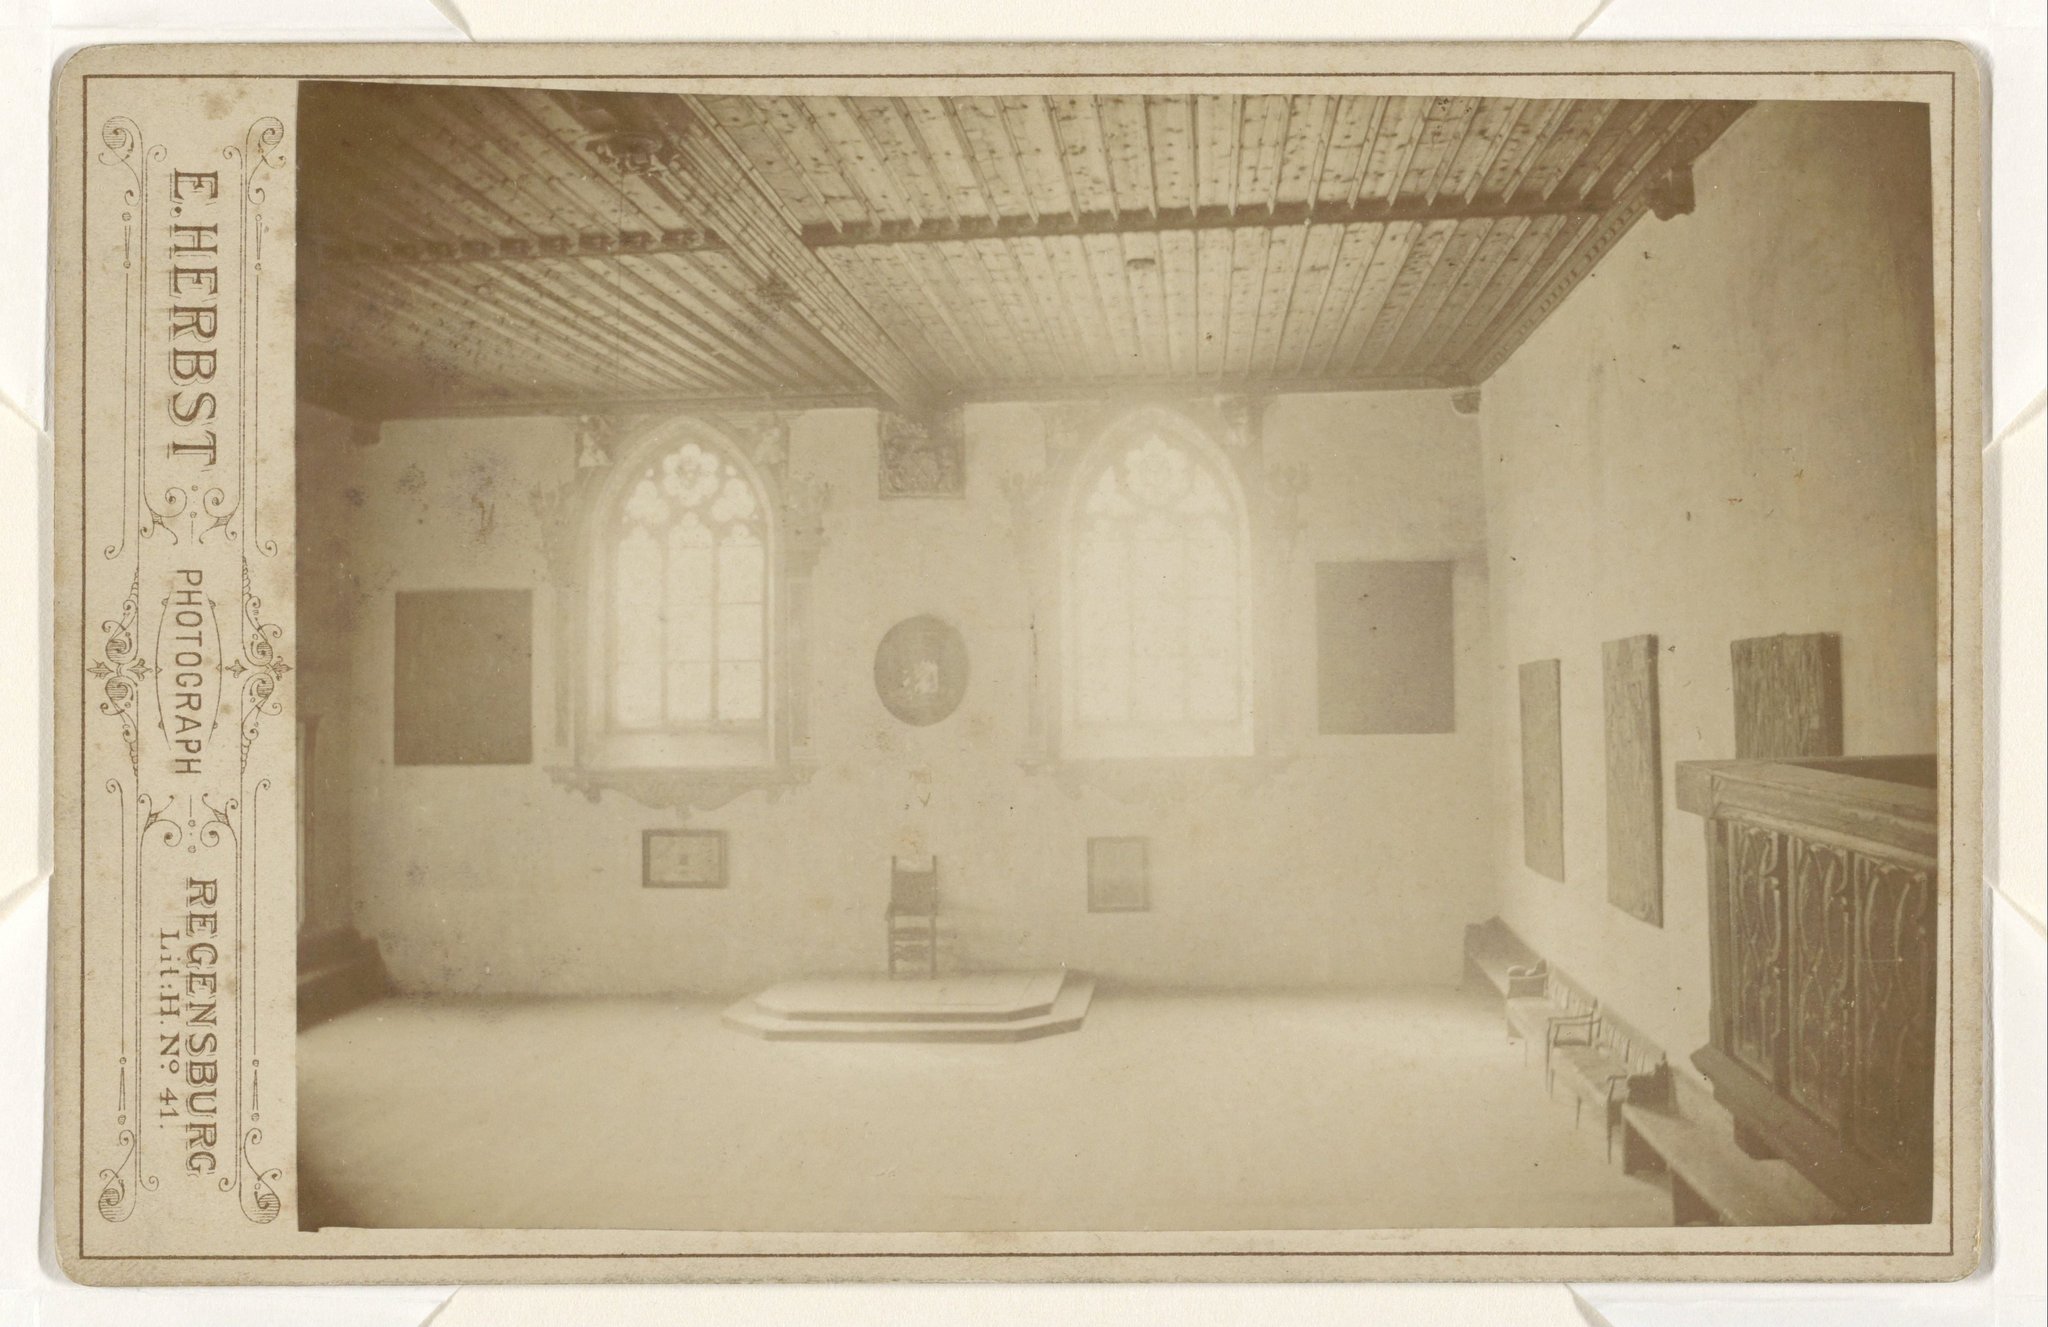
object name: cabinet photograph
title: Interieur van een huis of kerk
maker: emil herbst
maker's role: fotograaf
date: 1876-1891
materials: cardboard, paper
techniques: albumen print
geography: regensburg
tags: townhall, interior of the house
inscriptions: inscription: ‘E. Herbst/ Photograph/ Regensburg/ Lith: H. No. 41.’